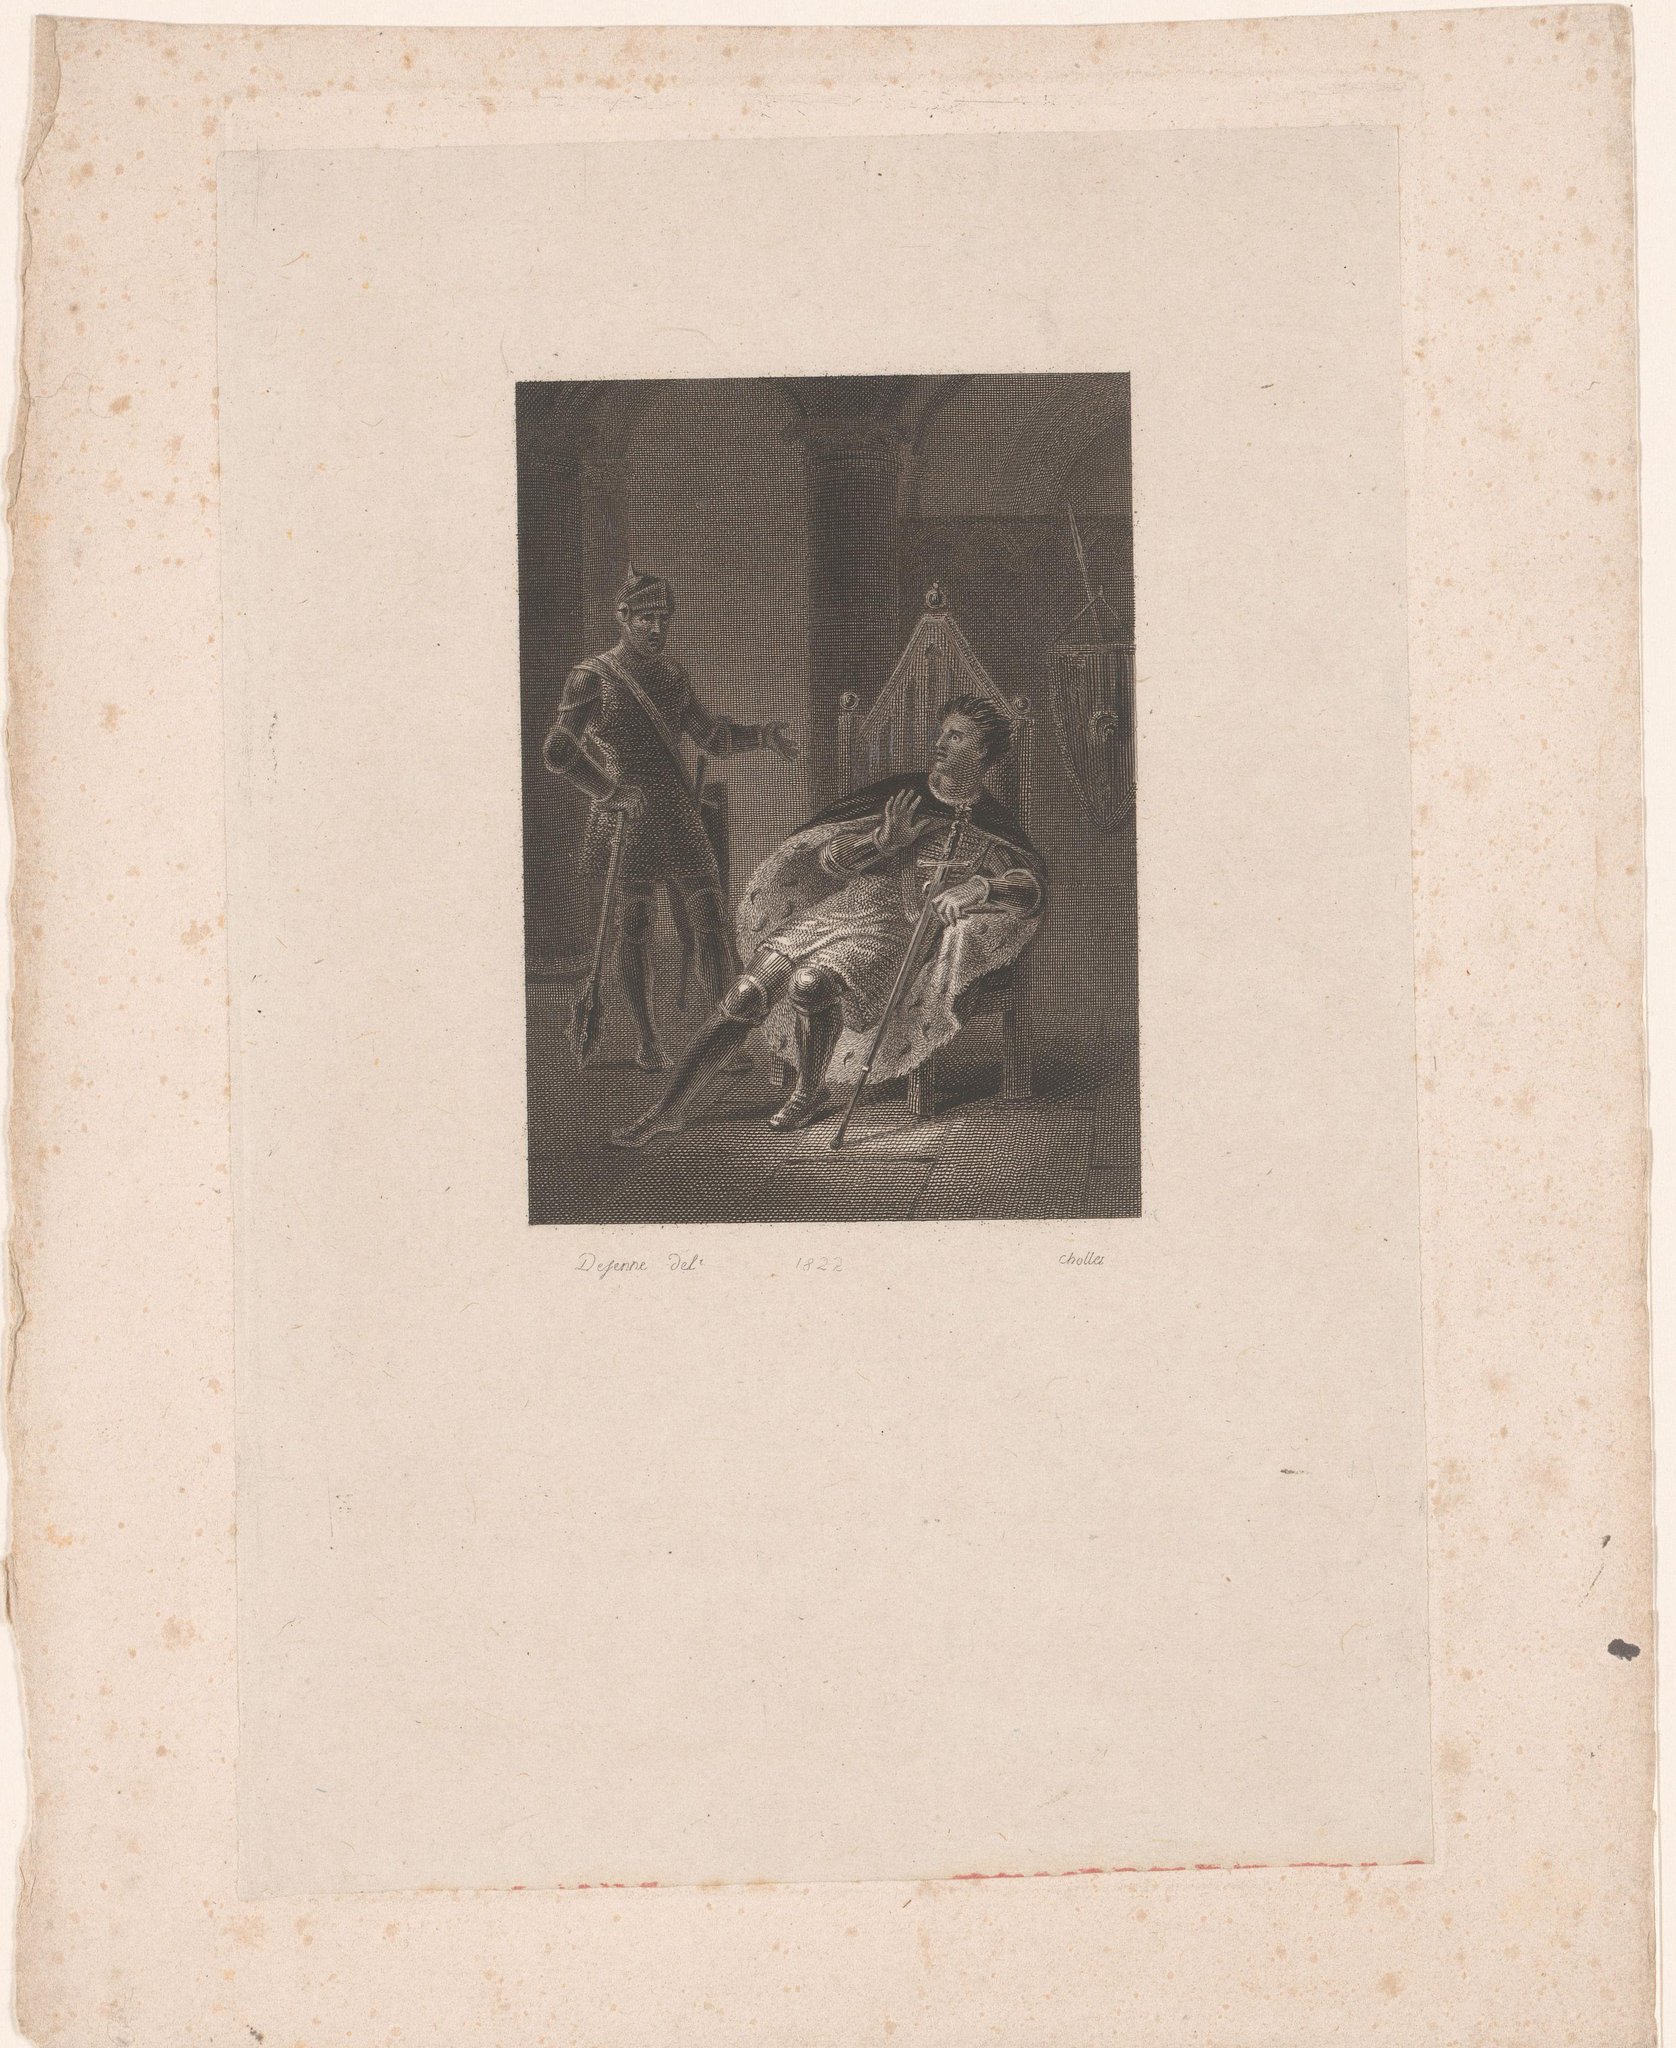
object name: print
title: Koning en ridder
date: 1822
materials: paper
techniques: engraving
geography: france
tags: ruler, sovereign, knight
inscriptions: collector's mark: Lugt 2228